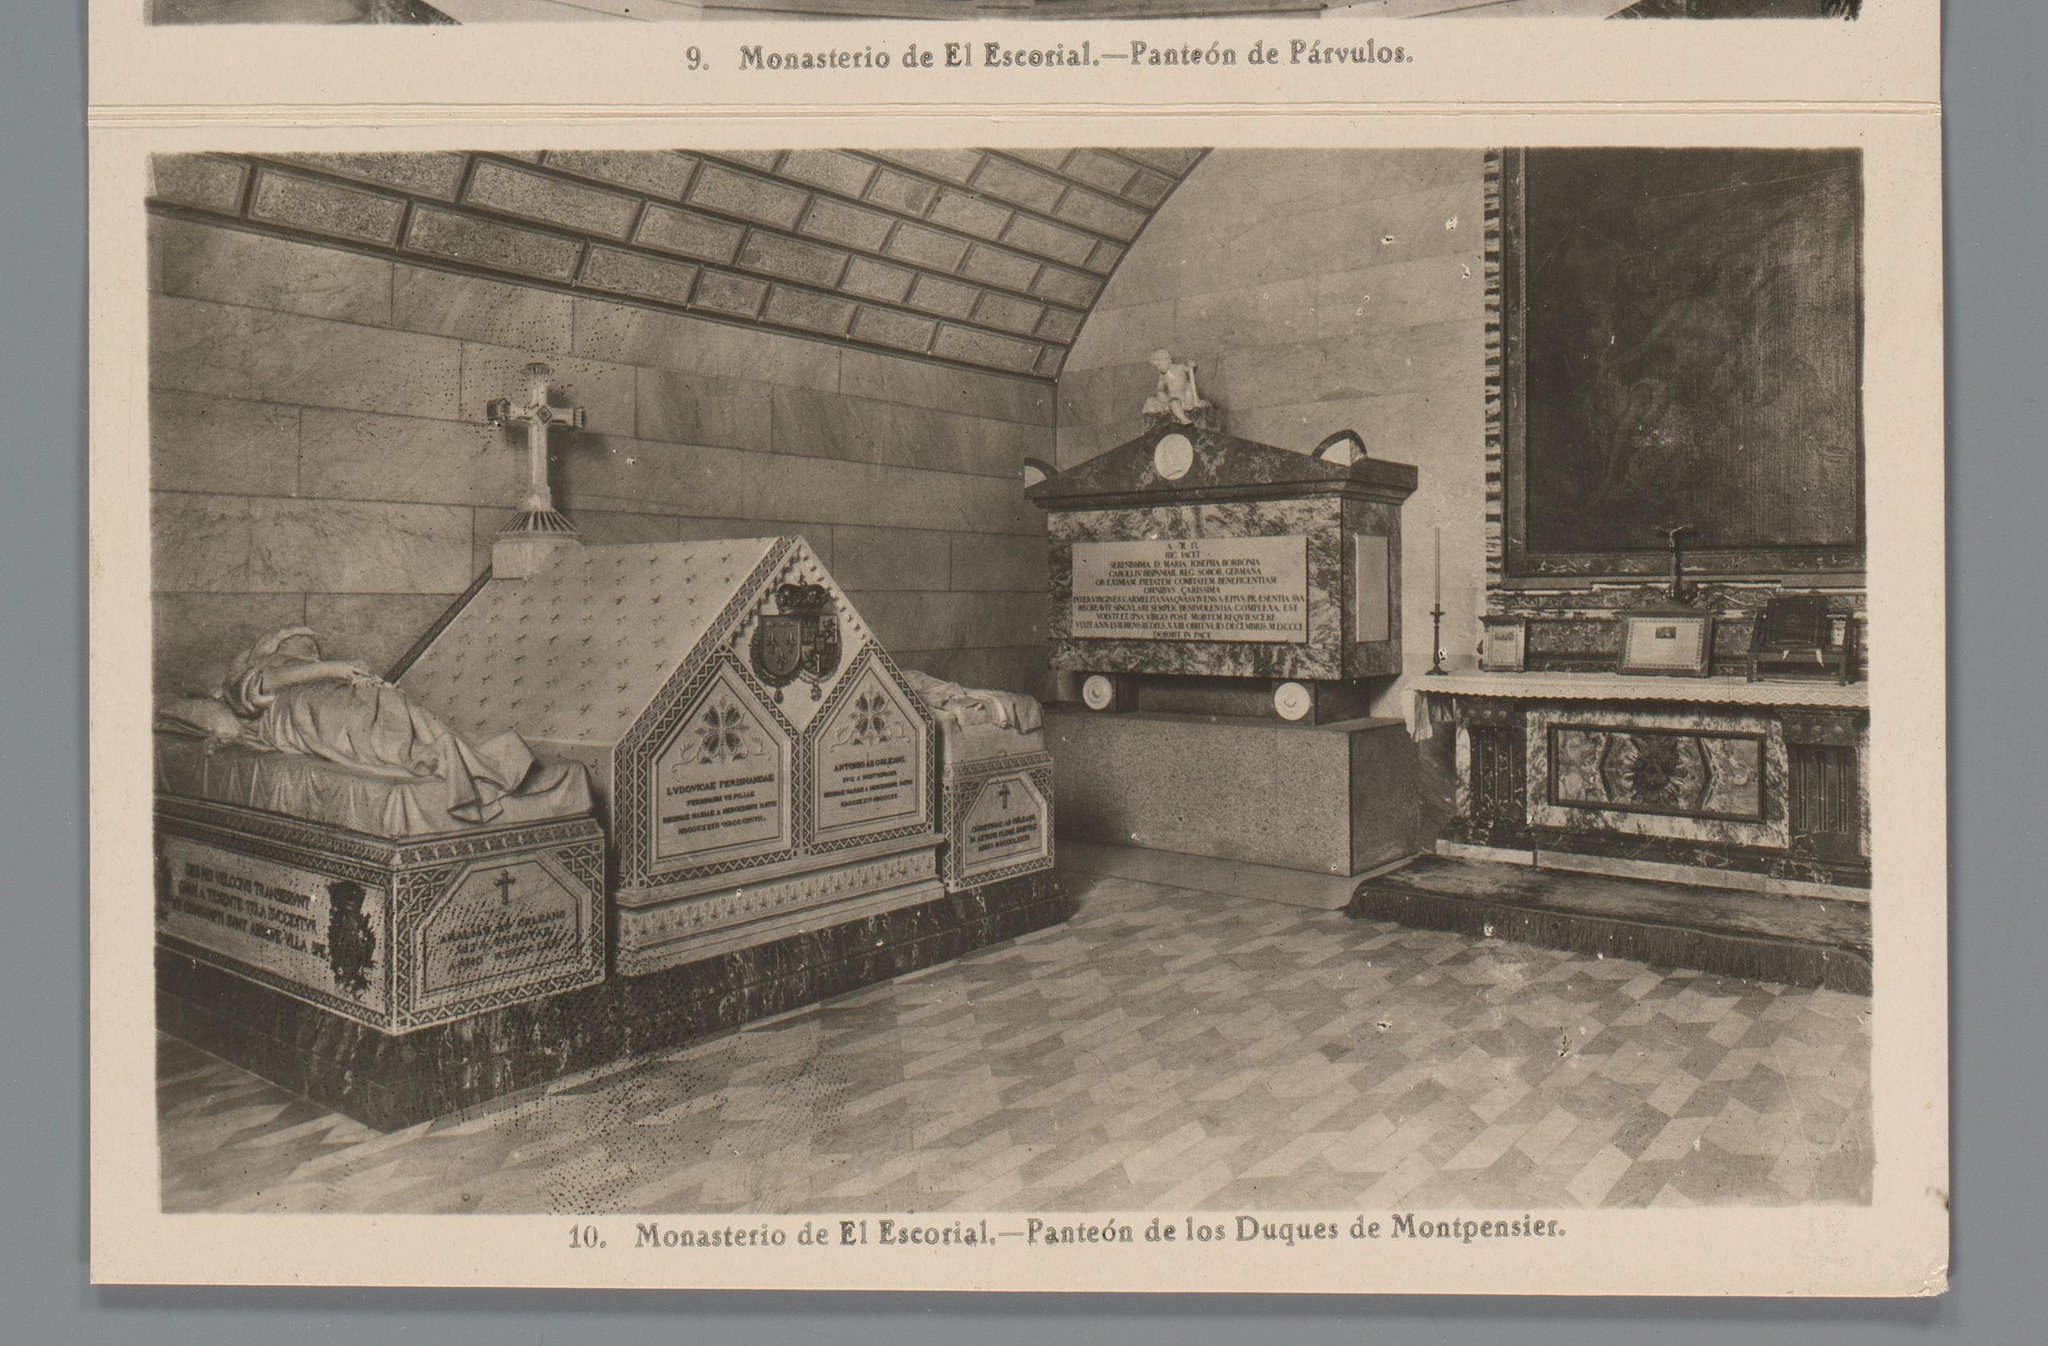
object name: ansichtkaart, prentbriefkaart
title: Monasterio de El Escorial - Panteón de los Duques de Montpensier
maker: Anonymous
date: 1918-1930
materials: paper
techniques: gelatin silver print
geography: madrid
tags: abbey, monastery, convent ~ roman catholic church, parts of church interior (crypt)